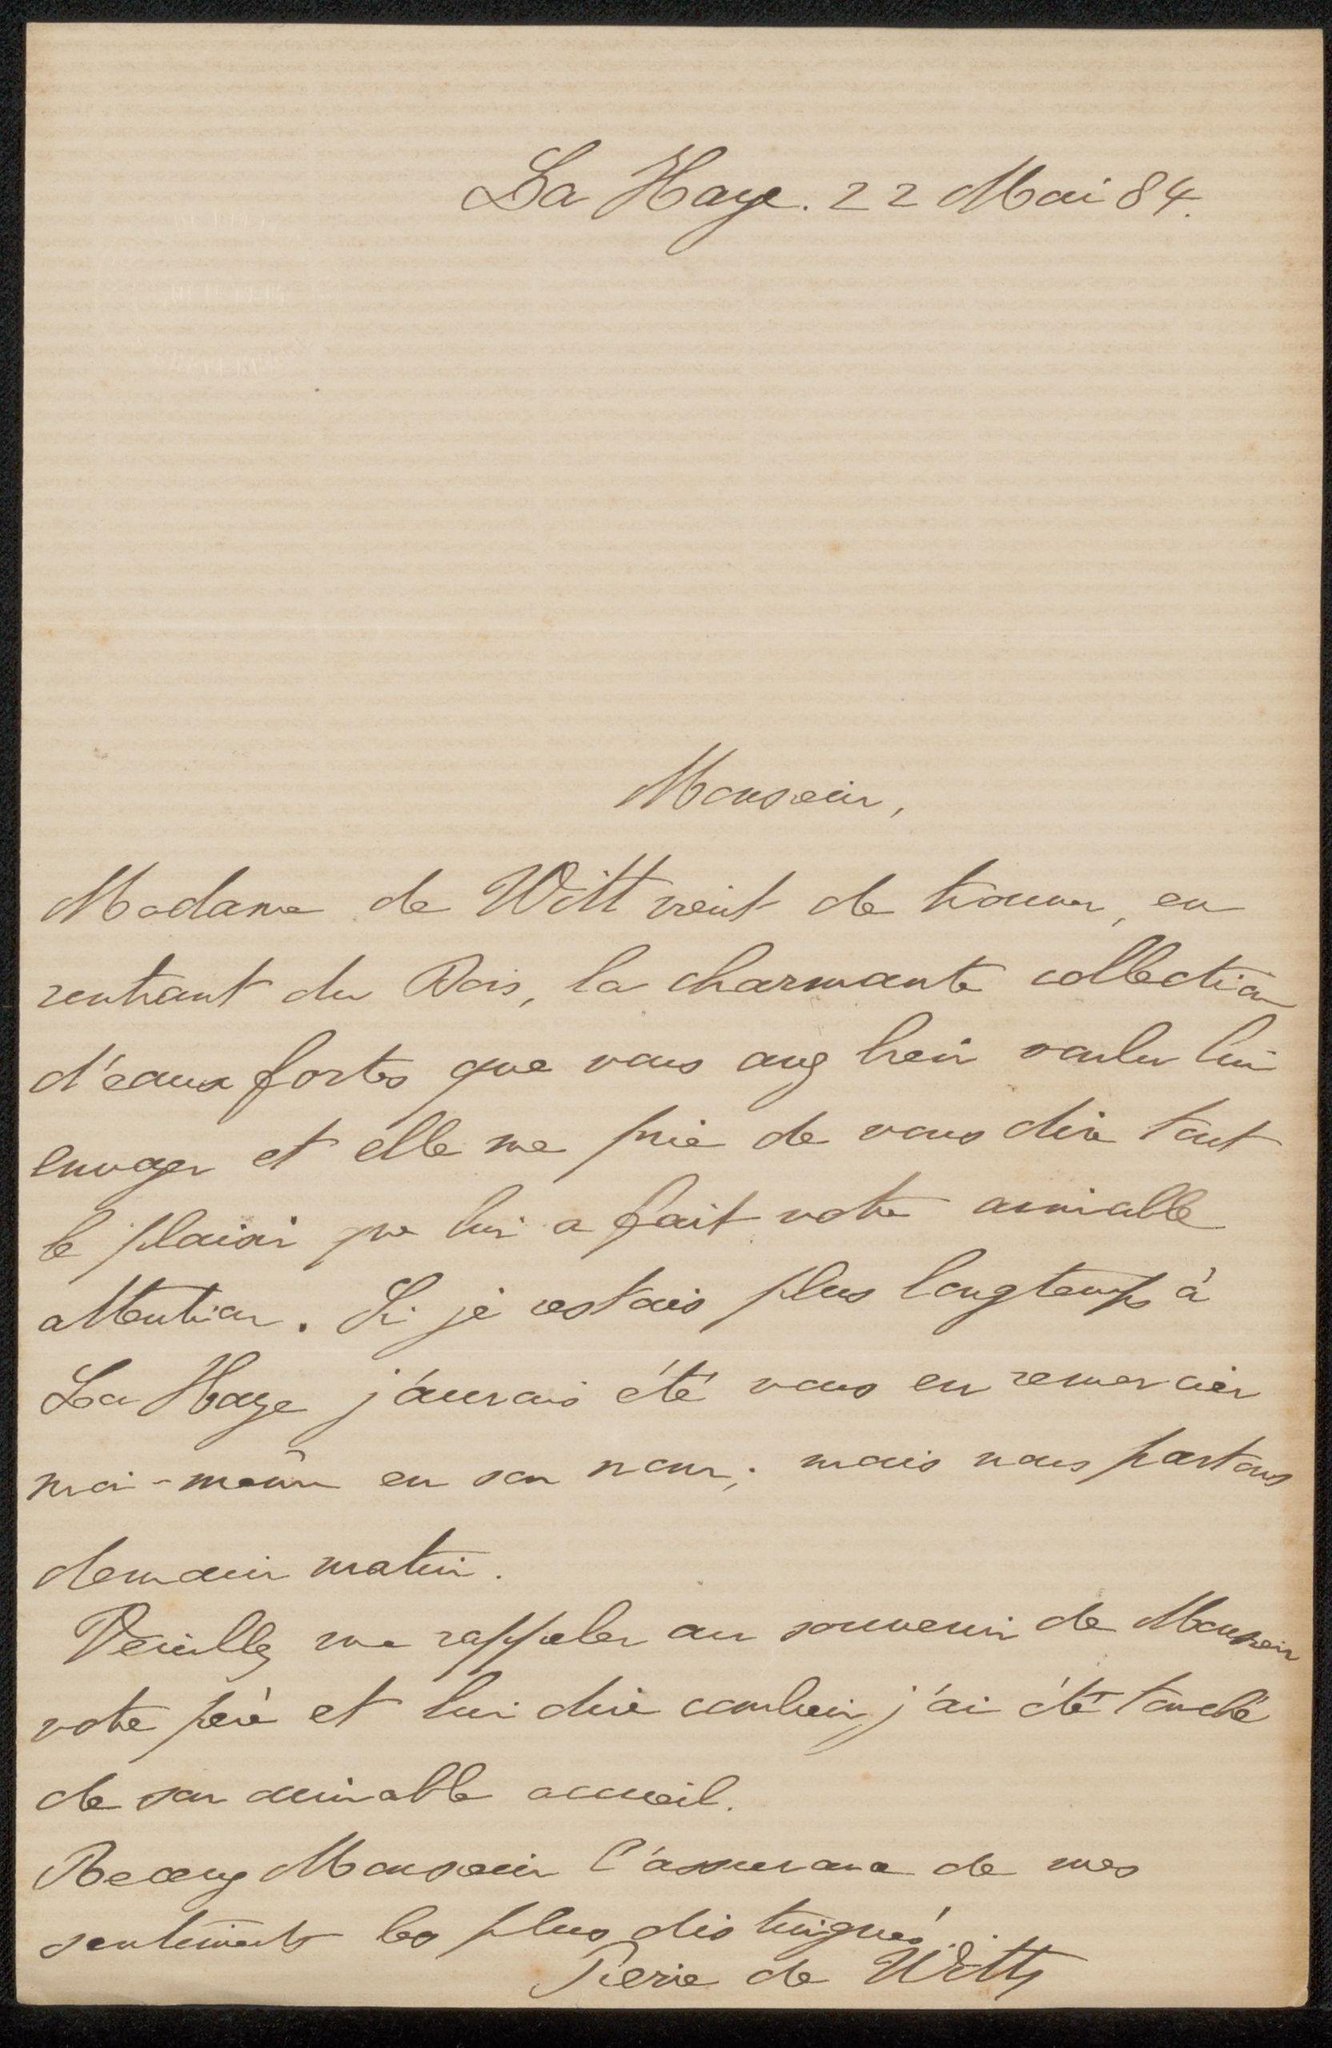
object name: letter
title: Brief aan Philip Zilcken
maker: pierre de witt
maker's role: schrijver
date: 1884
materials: ink, paper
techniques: pen, writing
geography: the hague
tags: painter, philip zilcken, the graphic arts, the hague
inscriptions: name: ‘NIEUWE DE LITTERAIRE/ SOCIETEIT/ 'S GRAVENHAGE’, collector's mark: ‘RPK’